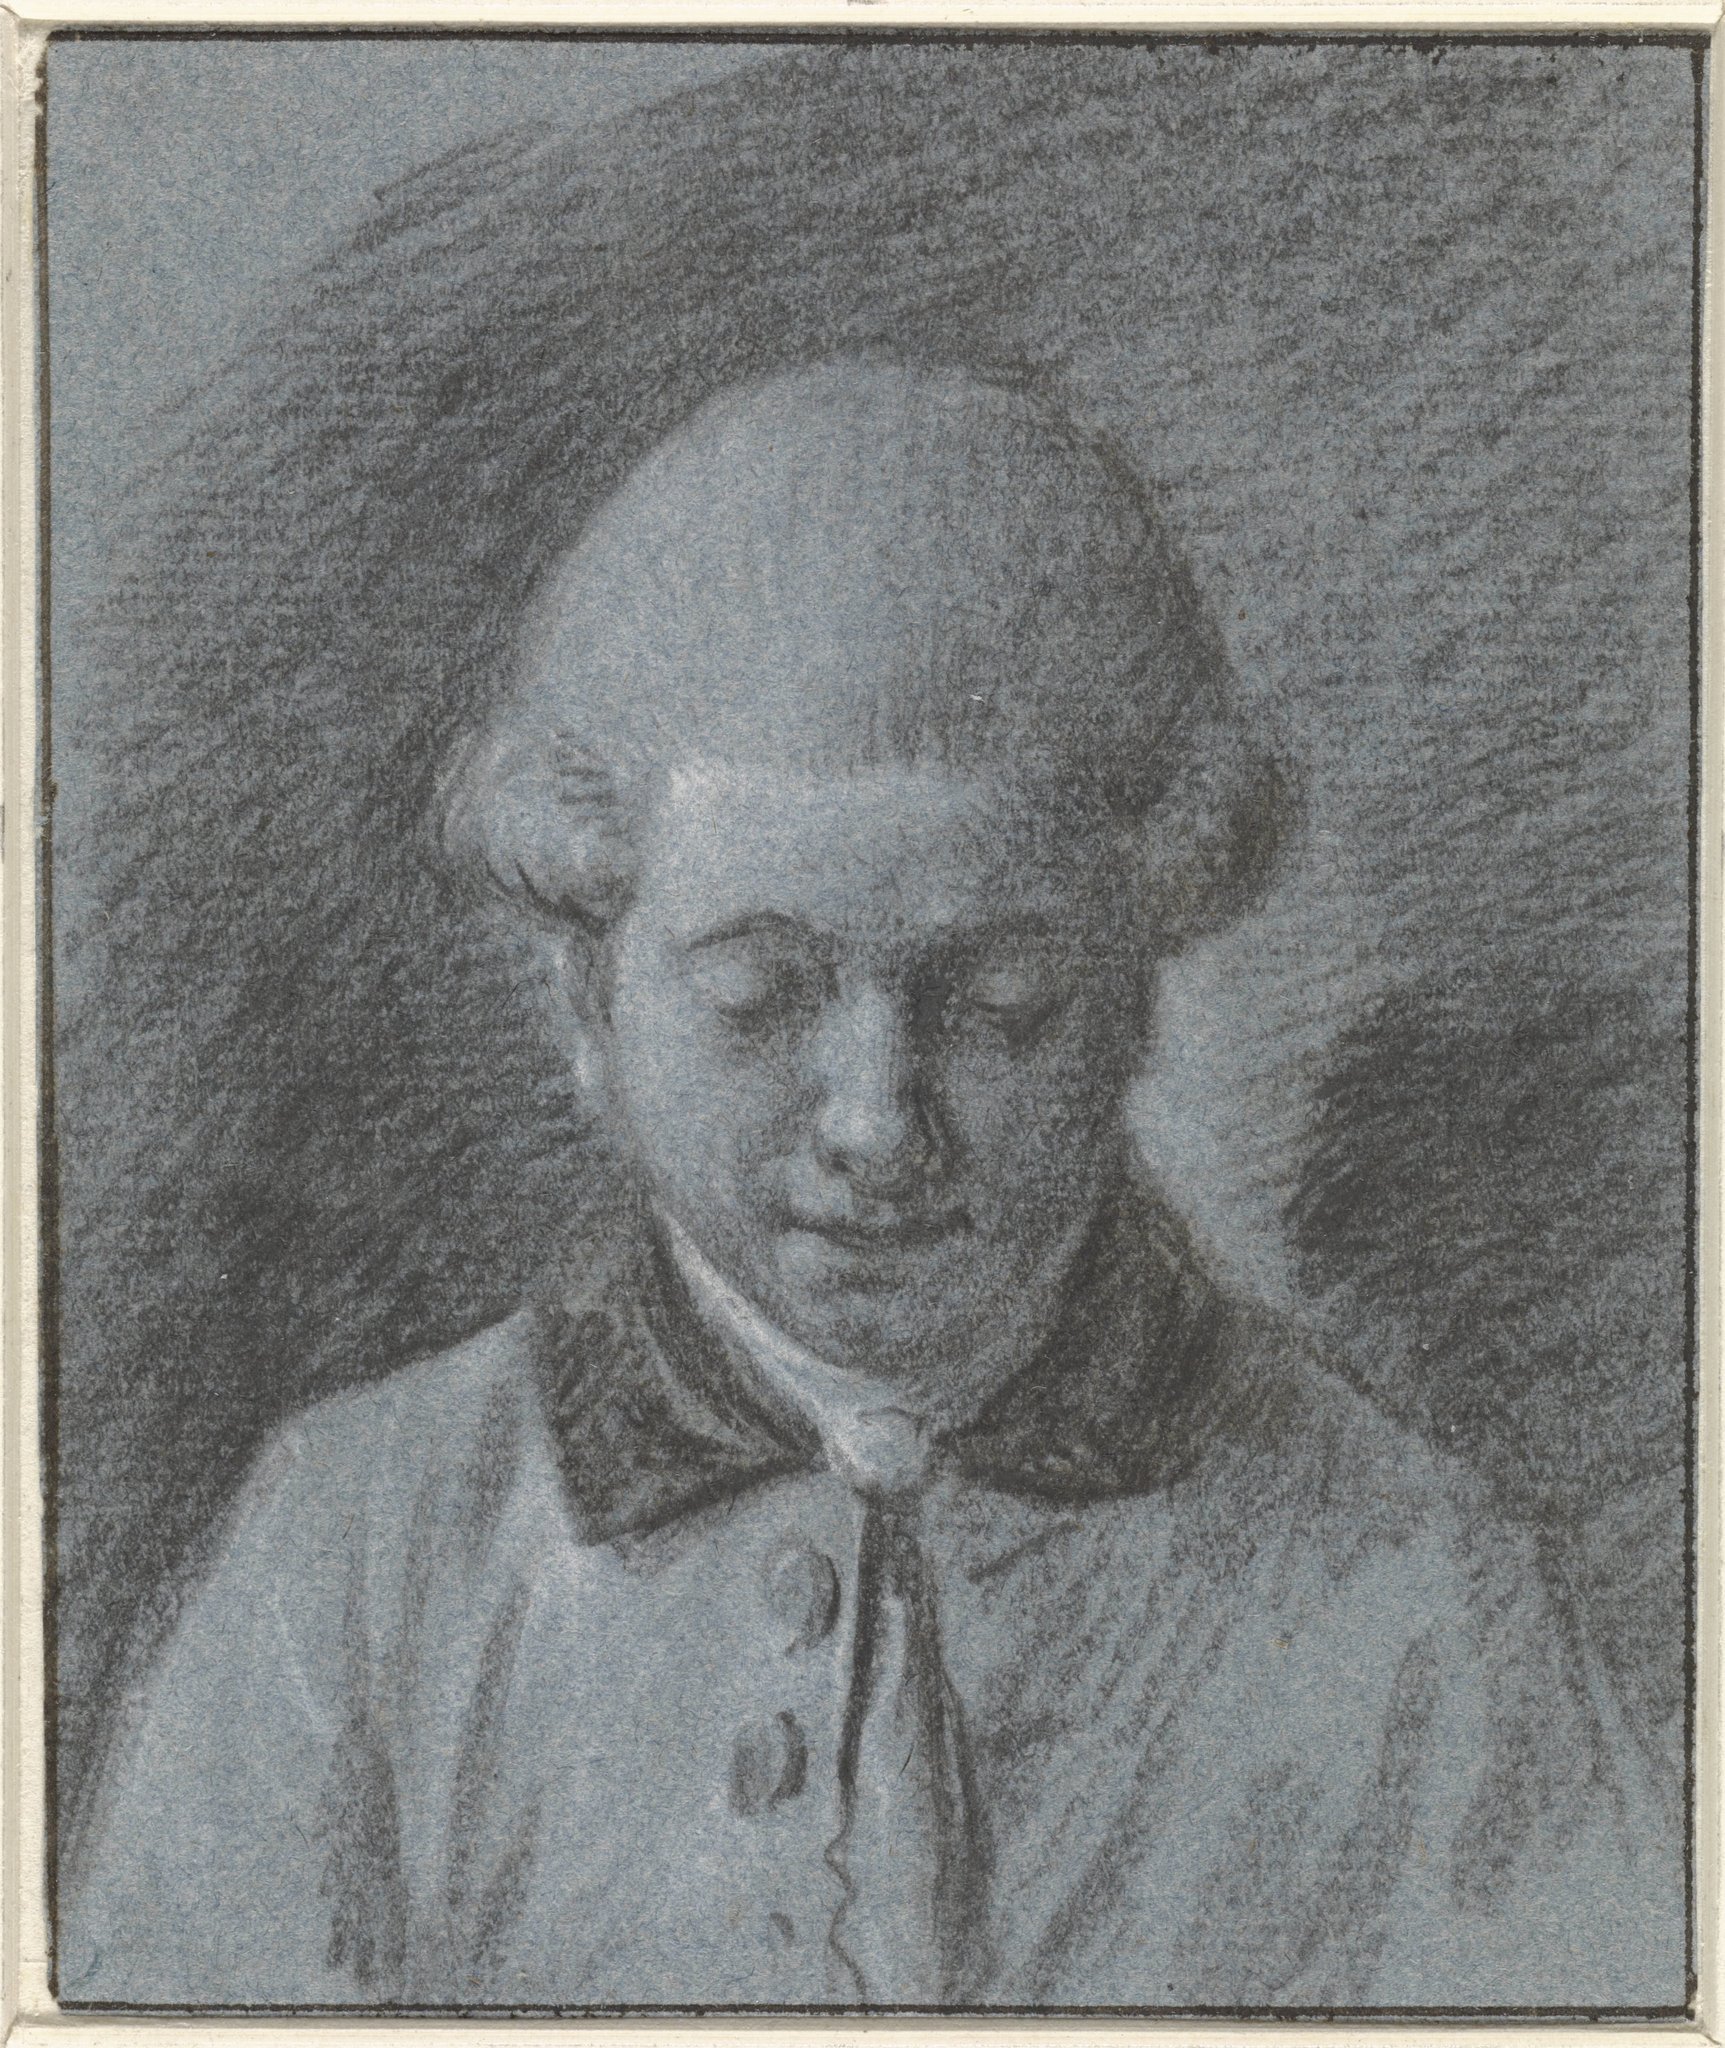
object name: drawing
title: Portret van Jean Grandjean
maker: Anonymous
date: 1770-1800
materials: chalk, paper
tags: amsterdam, rome, print maker, draughtsman, jean grandjean, historical persons, portrait, self-portrait of painter, portrait, self-portrait of artist, portrait, self-portrait of draughtsman